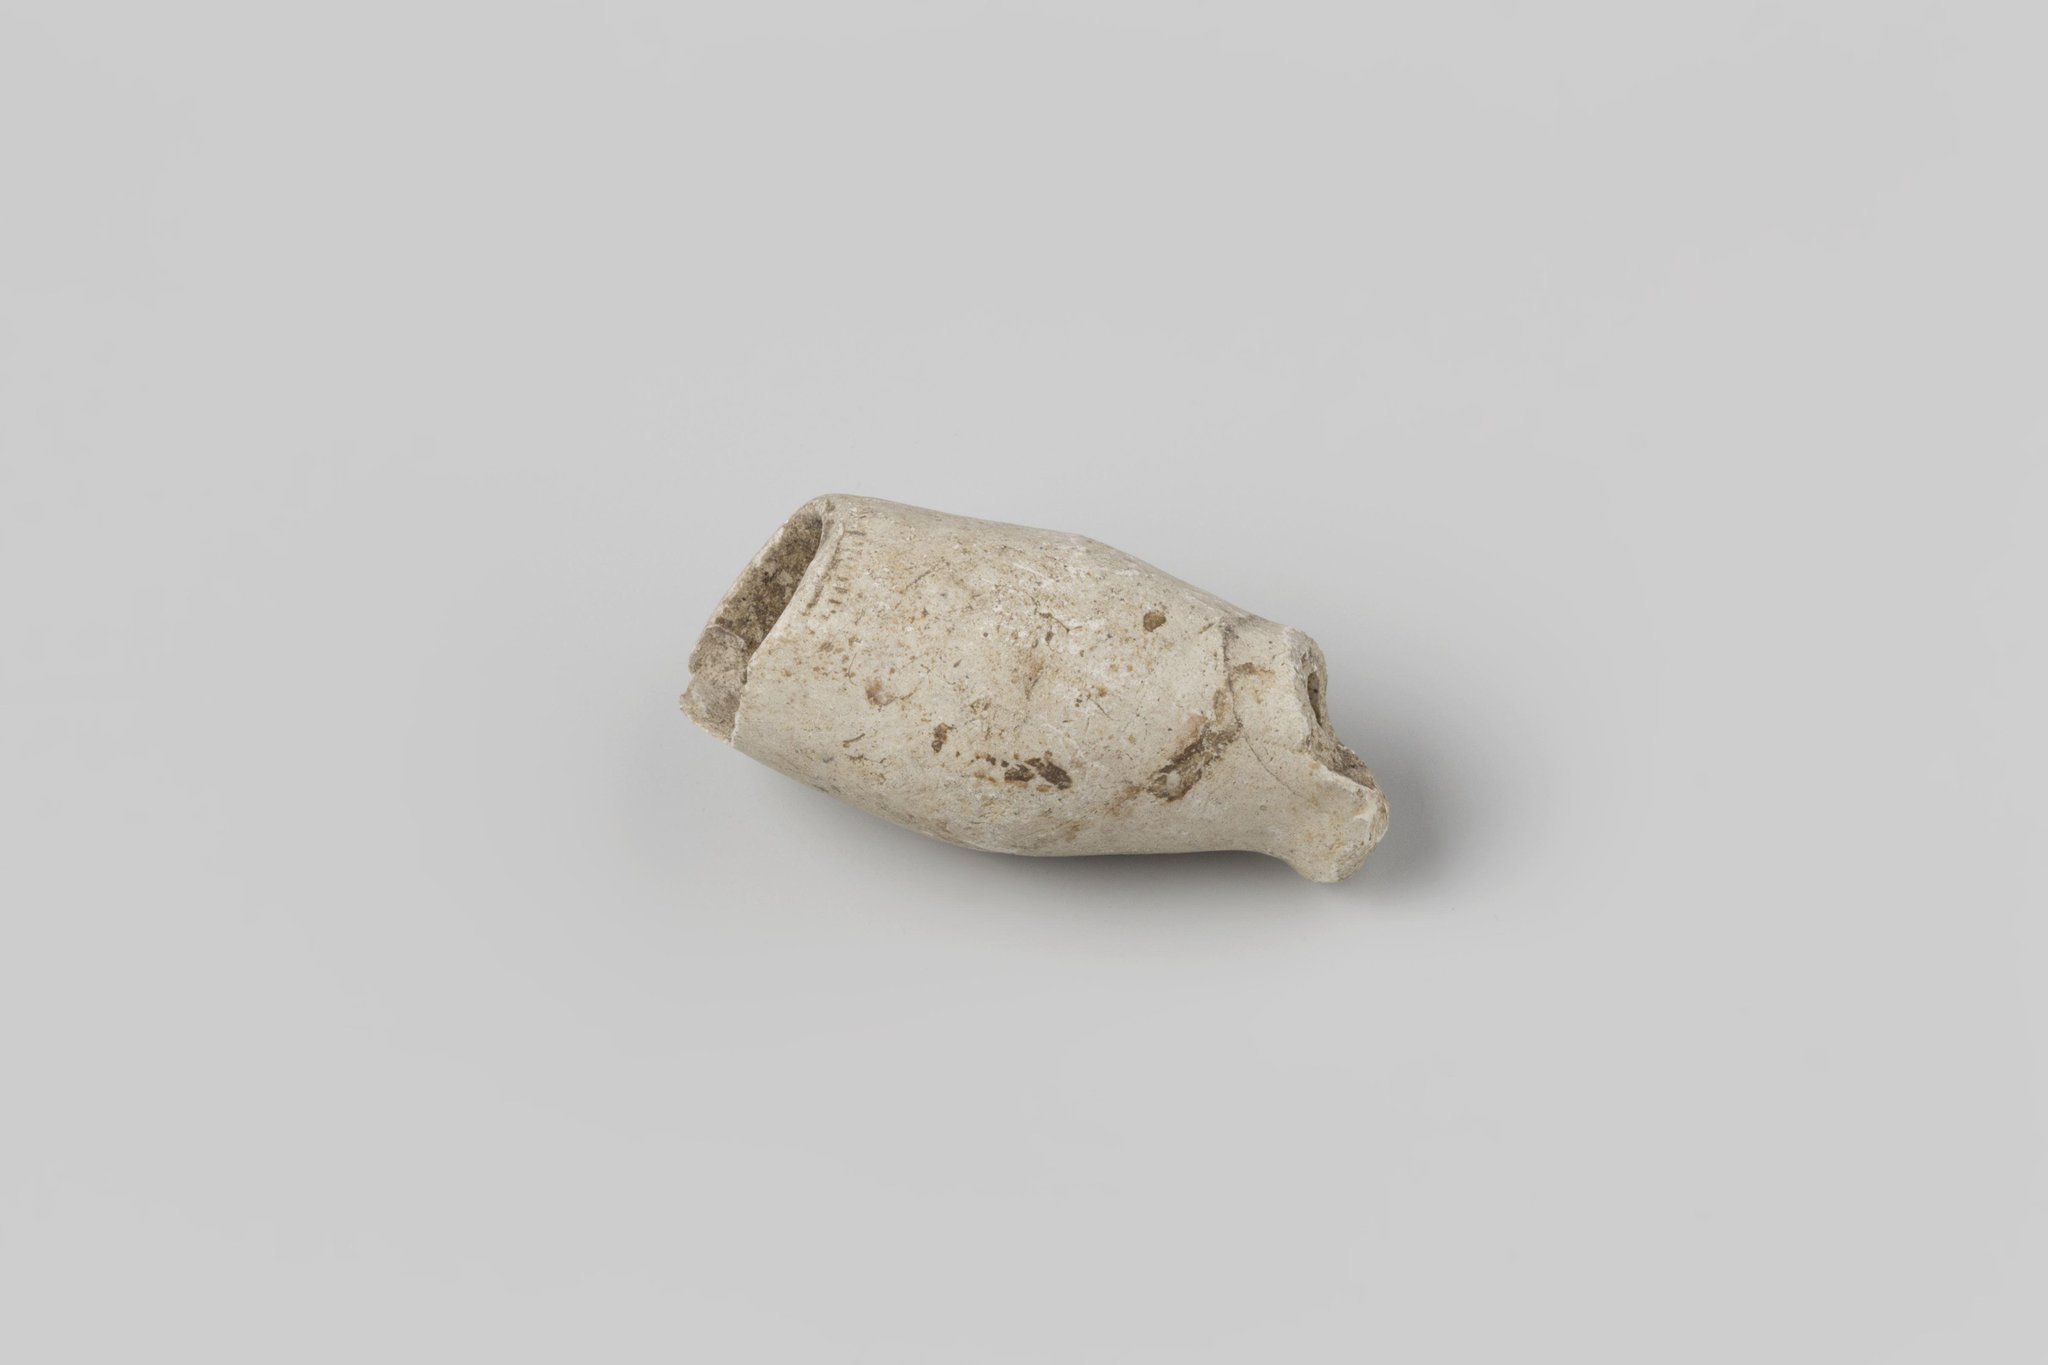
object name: fragment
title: Fragment pijpenkop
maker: Anonymous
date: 1600-1699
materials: clay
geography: netherlands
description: Fragment pijpenkop. Van de opgravingen op de Hofstede Arentsburg 1827-1831 onder toezicht van Professor Reuvens.